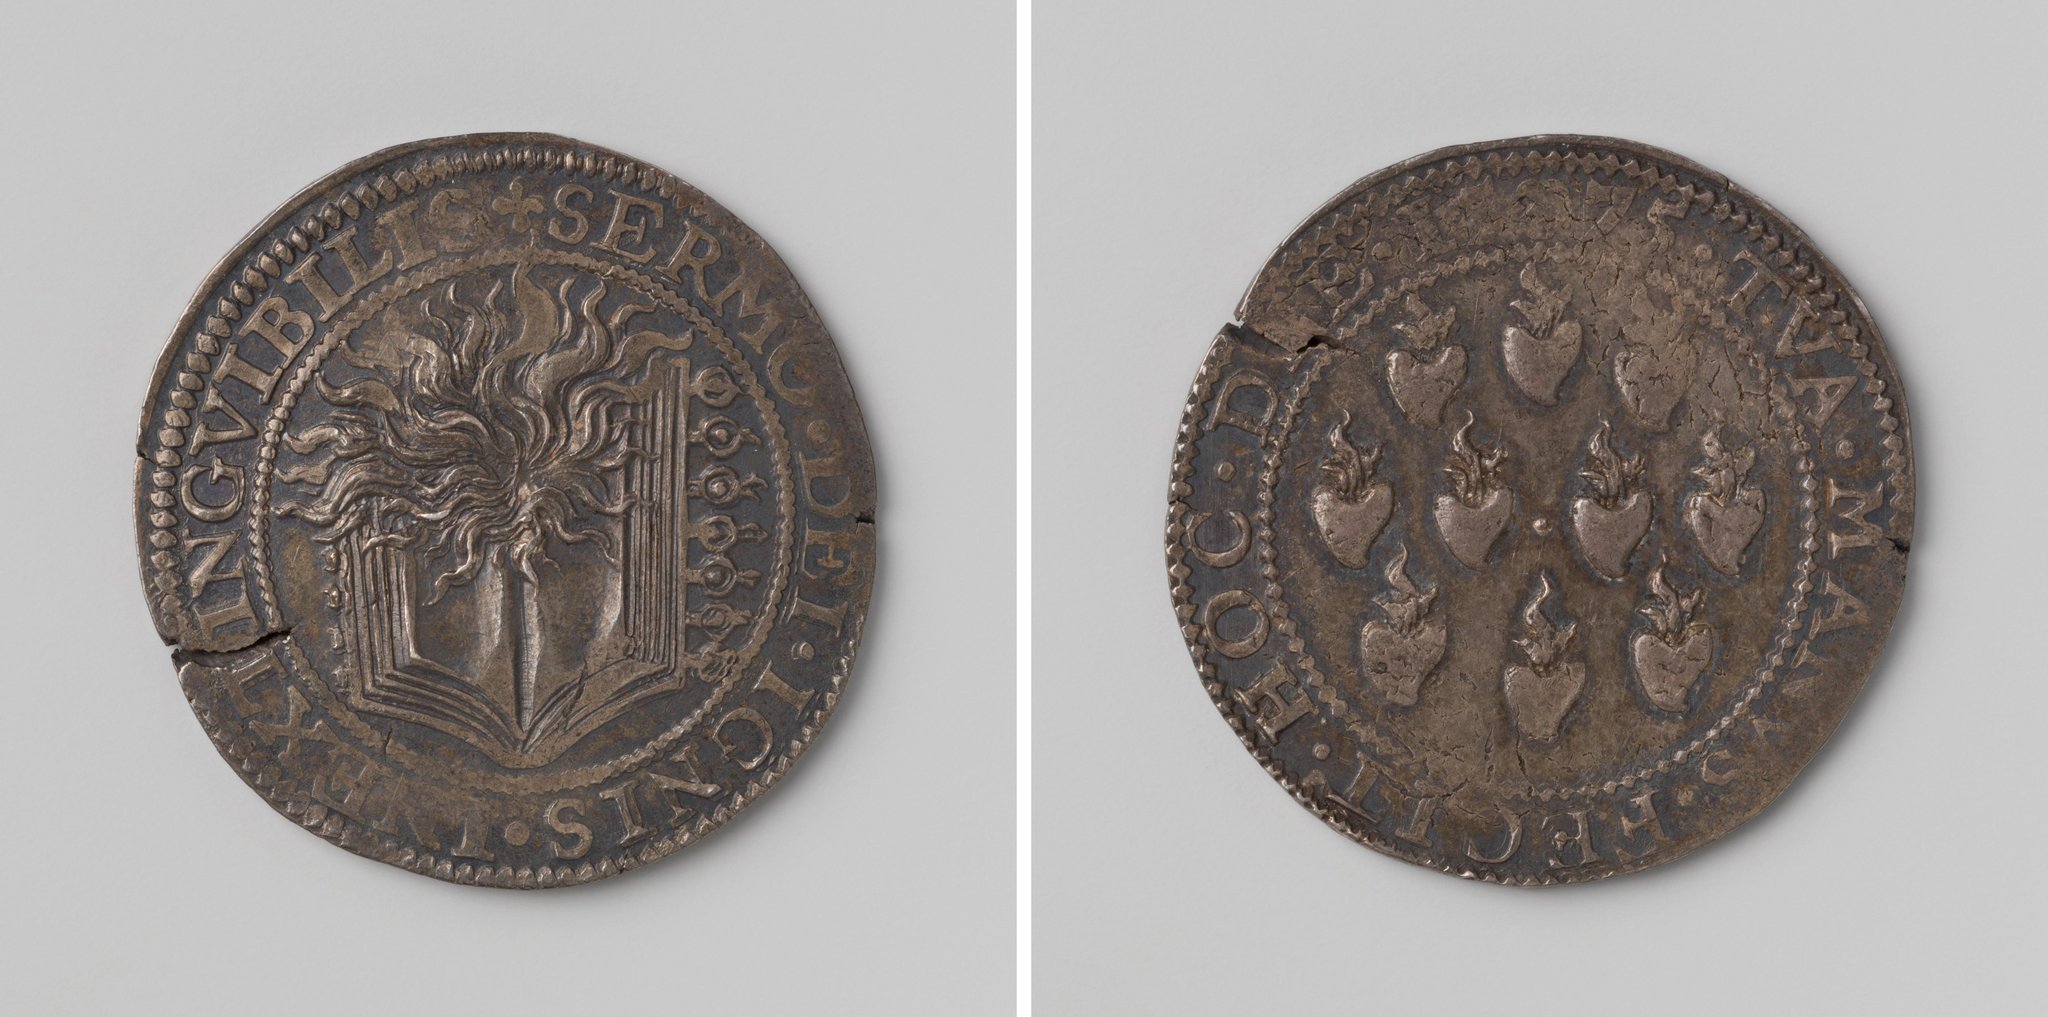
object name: jeton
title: Godsdienstijver van de Staten van Holland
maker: Anonymous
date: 1575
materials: silver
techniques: striking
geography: dordrecht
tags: holland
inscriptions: circumscription: ‘SERMO DEI IGNIS INEXTINGVIBILIS’, circumscription: ‘TVA MANVS FECIT HOC DNE 1575’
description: Zilveren penning. Voorzijde: brandende bijbel met zeven zegels binnen omschrift. Keerzijde: tien brandende harten binnen omschrift